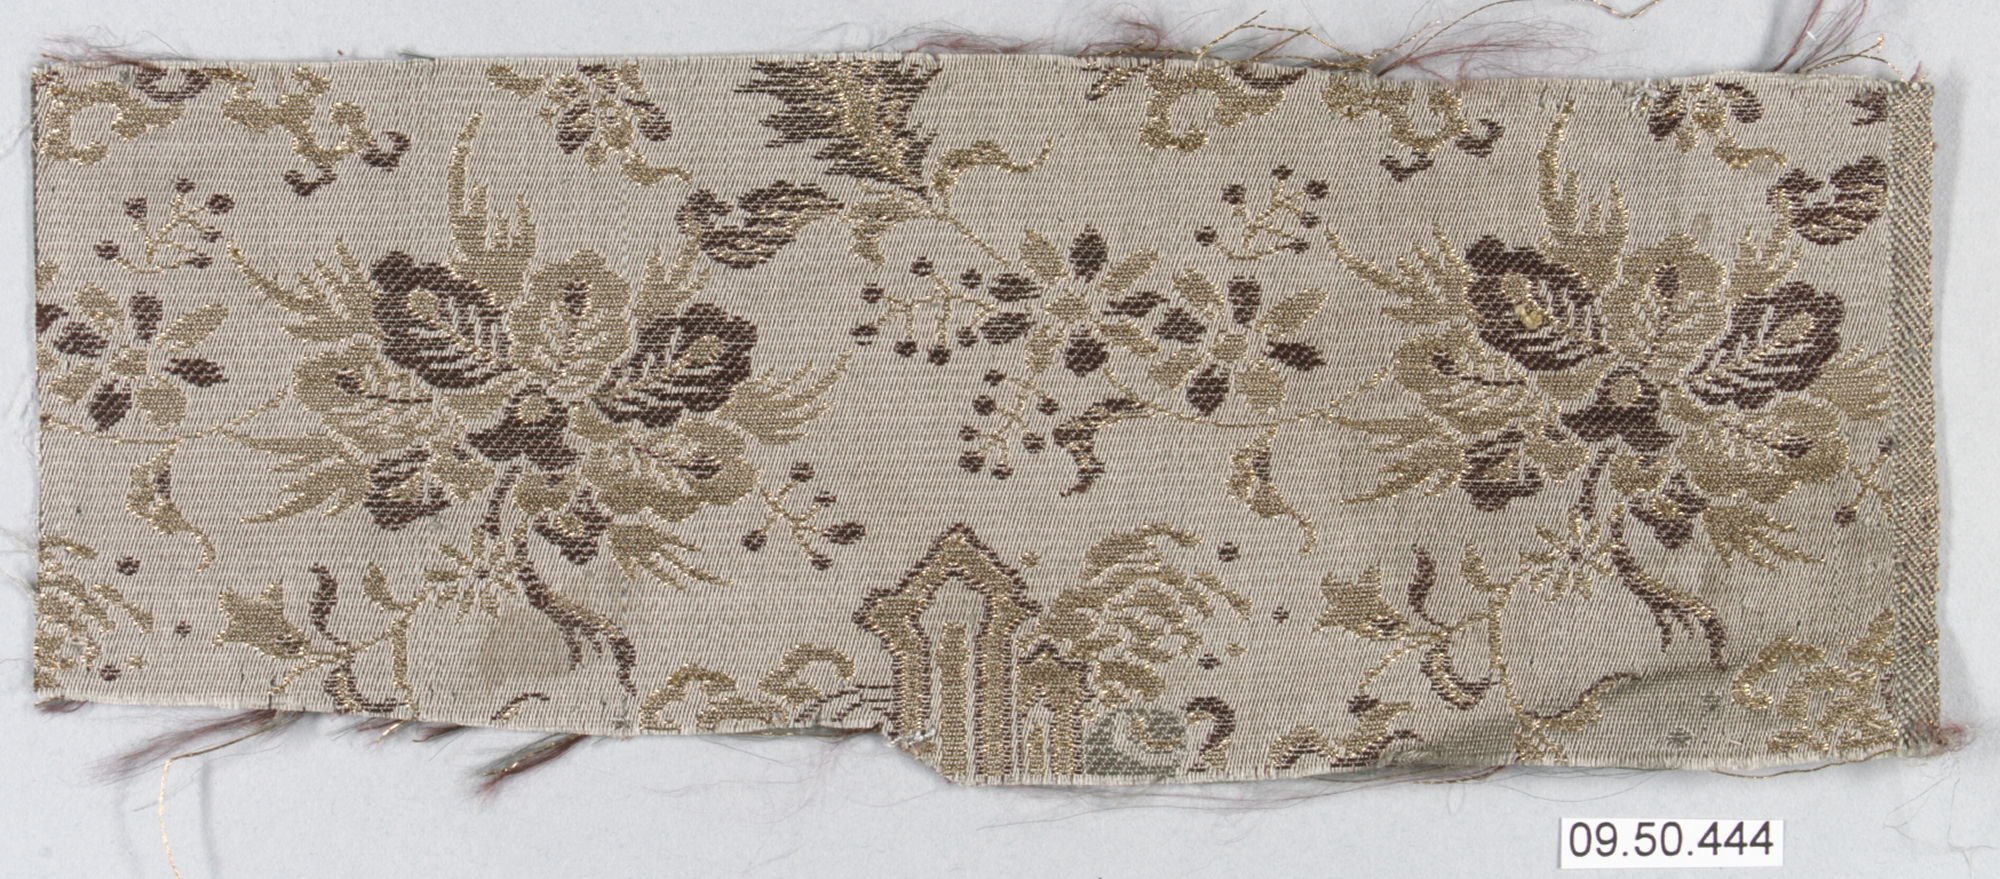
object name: piece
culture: japanese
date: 1801-1900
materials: metal thread, silk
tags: flowers